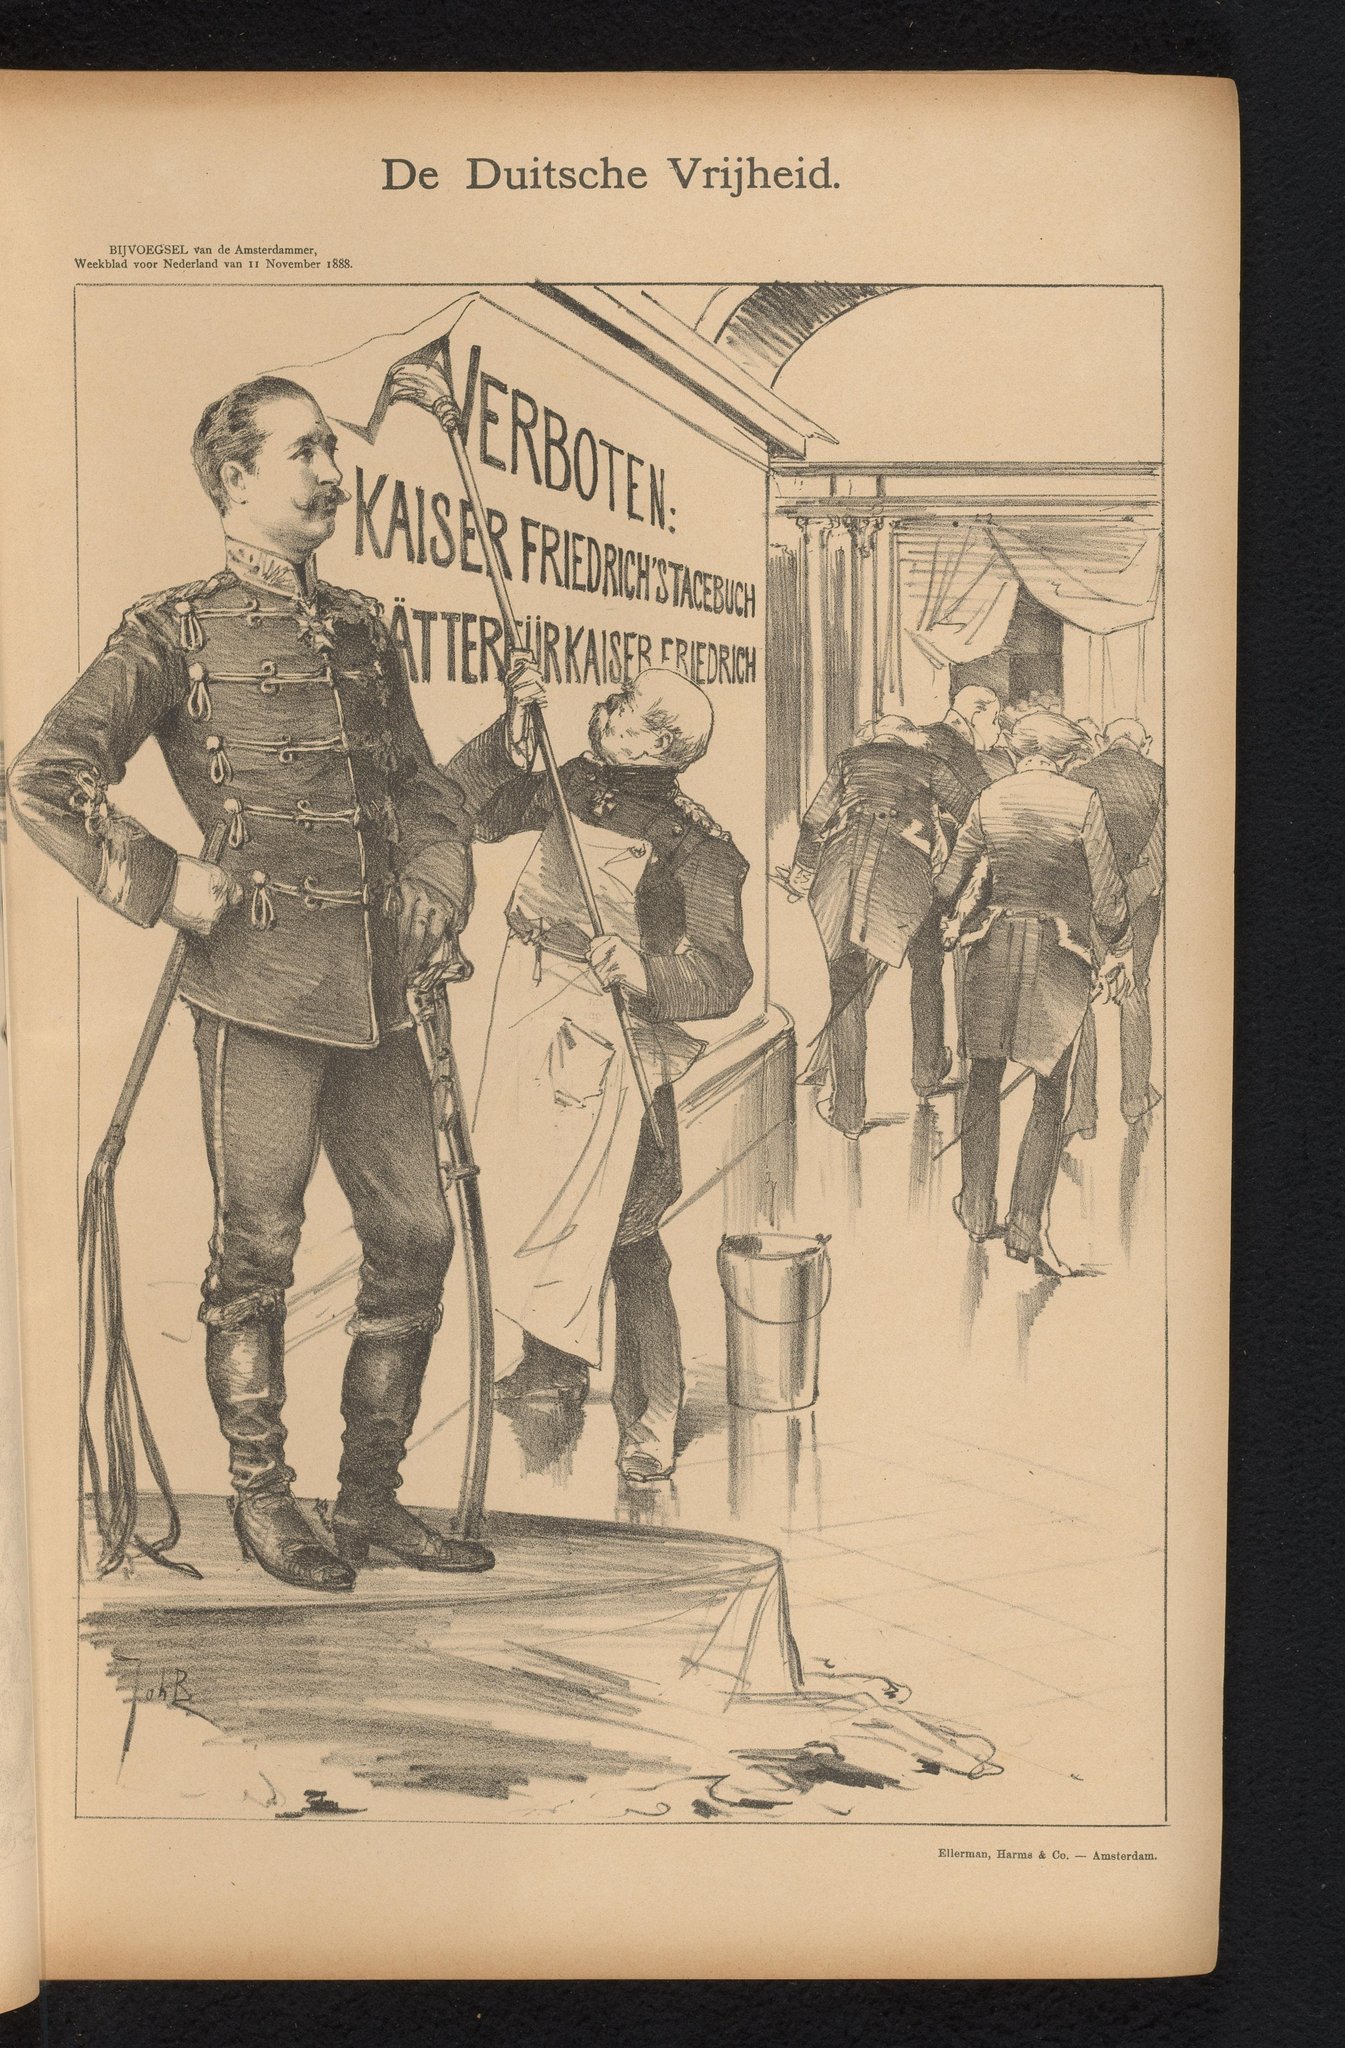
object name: cartoon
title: De Duitsche Vrijheid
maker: johan braakensiek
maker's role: draughtsman, print maker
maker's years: 1858-1940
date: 1888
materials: paper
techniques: lithograph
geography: amsterdam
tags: wilhelm ii (keizer van duitsland), censorship, historical persons, political caricatures and satires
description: De Duitse keizer Wilhelm II staande op een podium met een zweep in de hand. Achter hem plakt kanselier Bismarck plakkaten met verboden boektitels aan de wand.